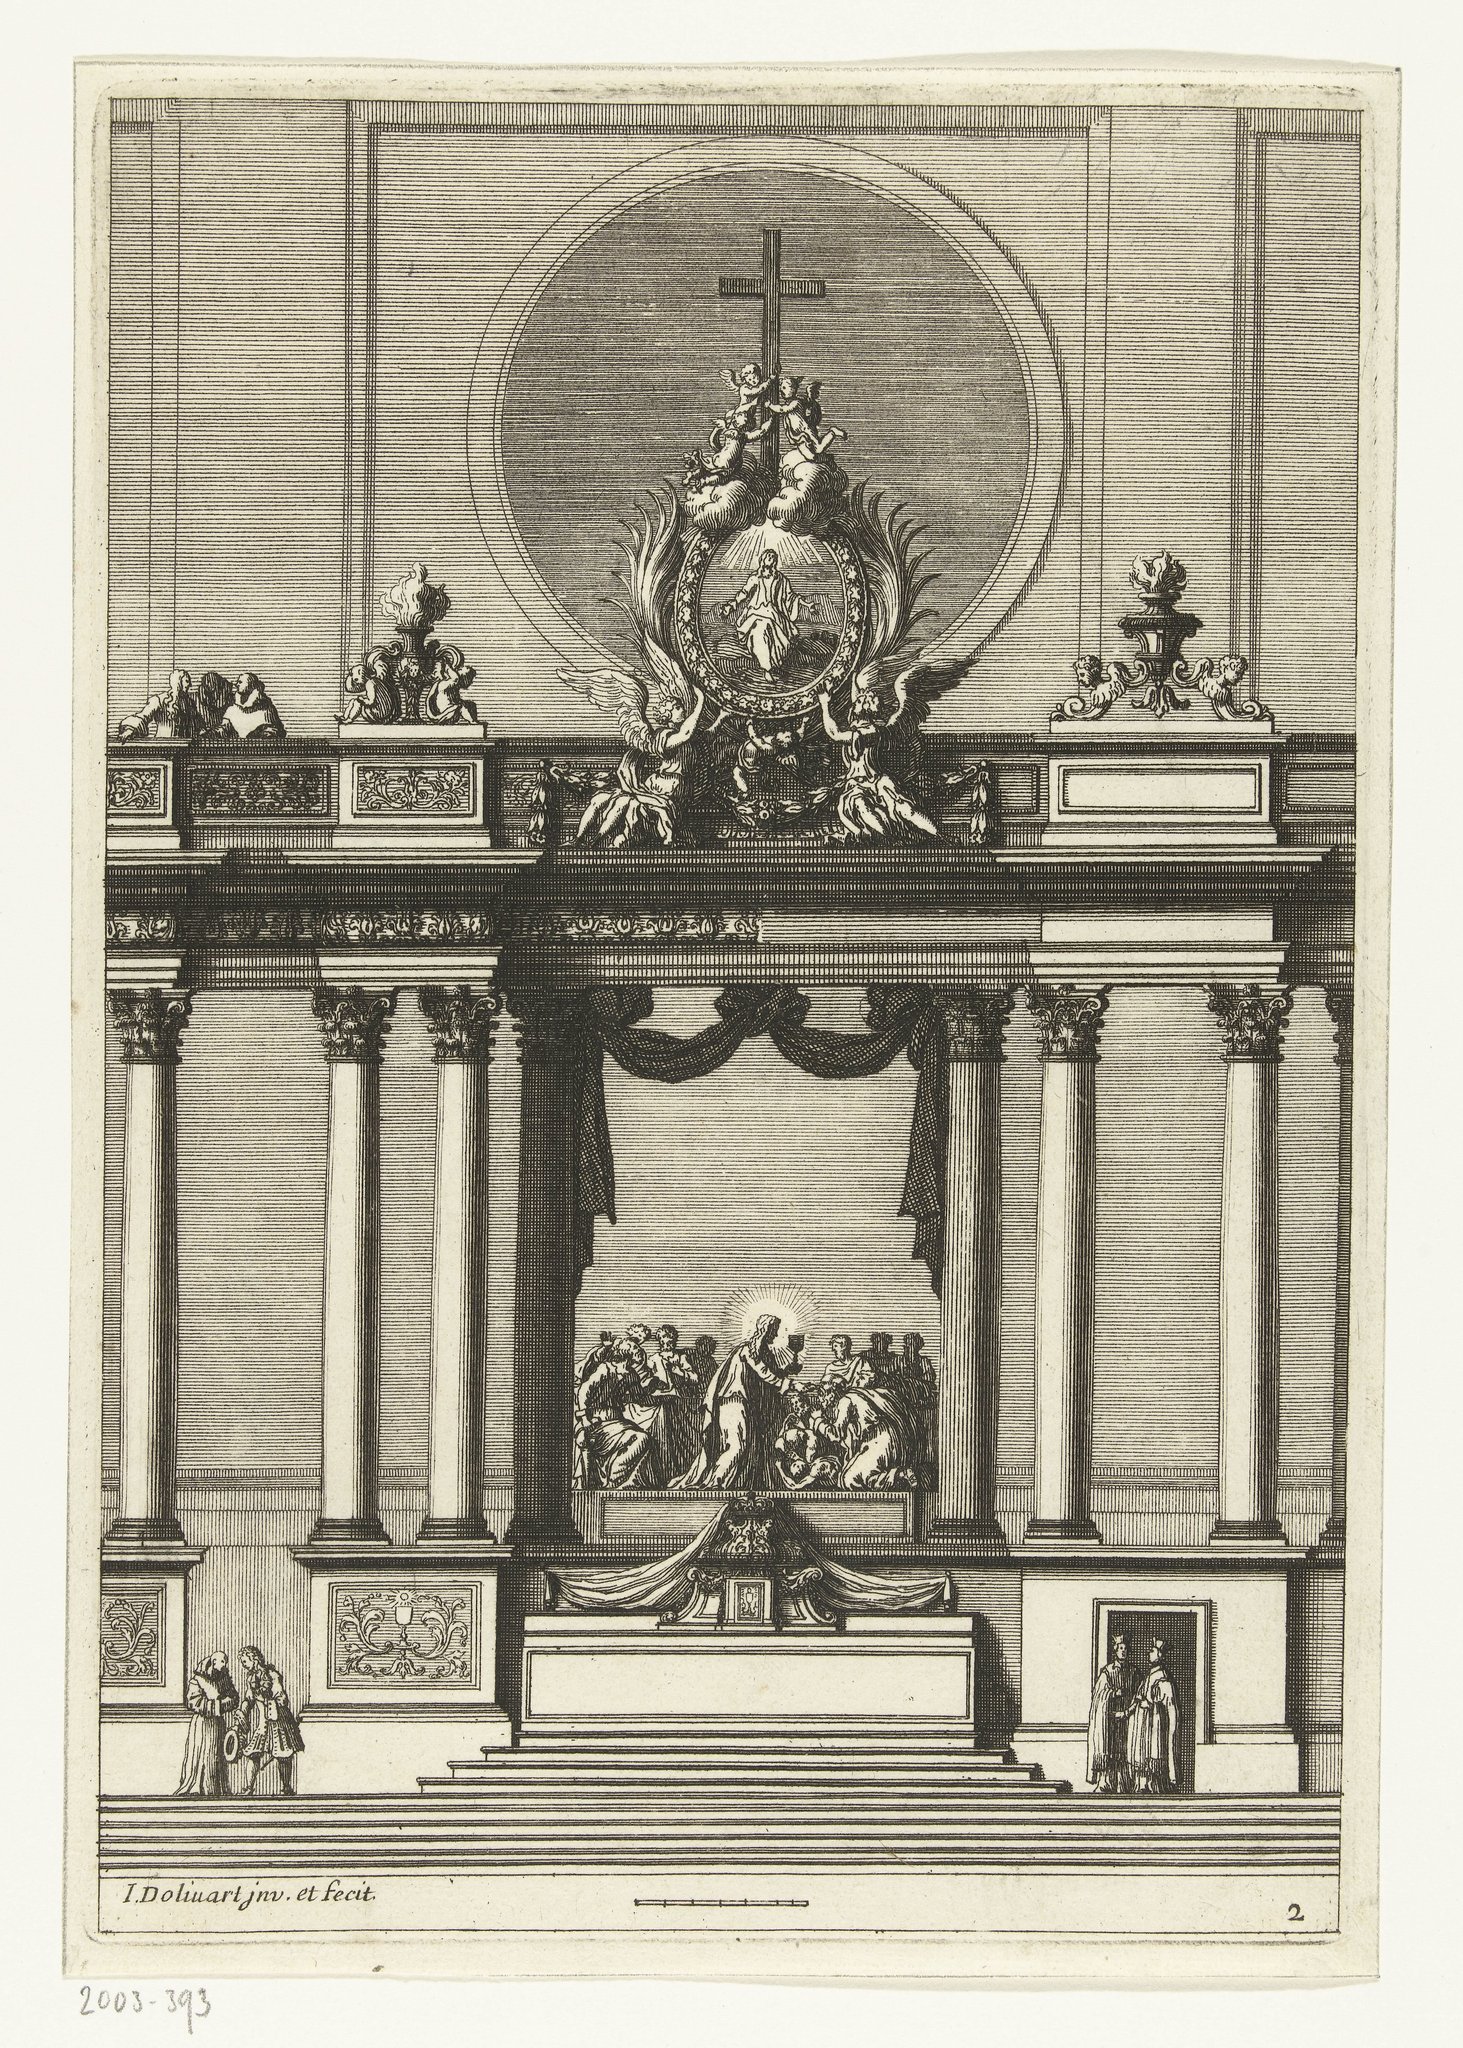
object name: ornament print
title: Ontwerp voor altaar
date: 1690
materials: paper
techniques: etching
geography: france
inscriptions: number: ‘2’, signature: ‘I. Dolivart jnv. et fecit’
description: Ontwerp voor altaar met voorstelling van het Laatste Avondmaal. Christus gaat met de kelk rond.